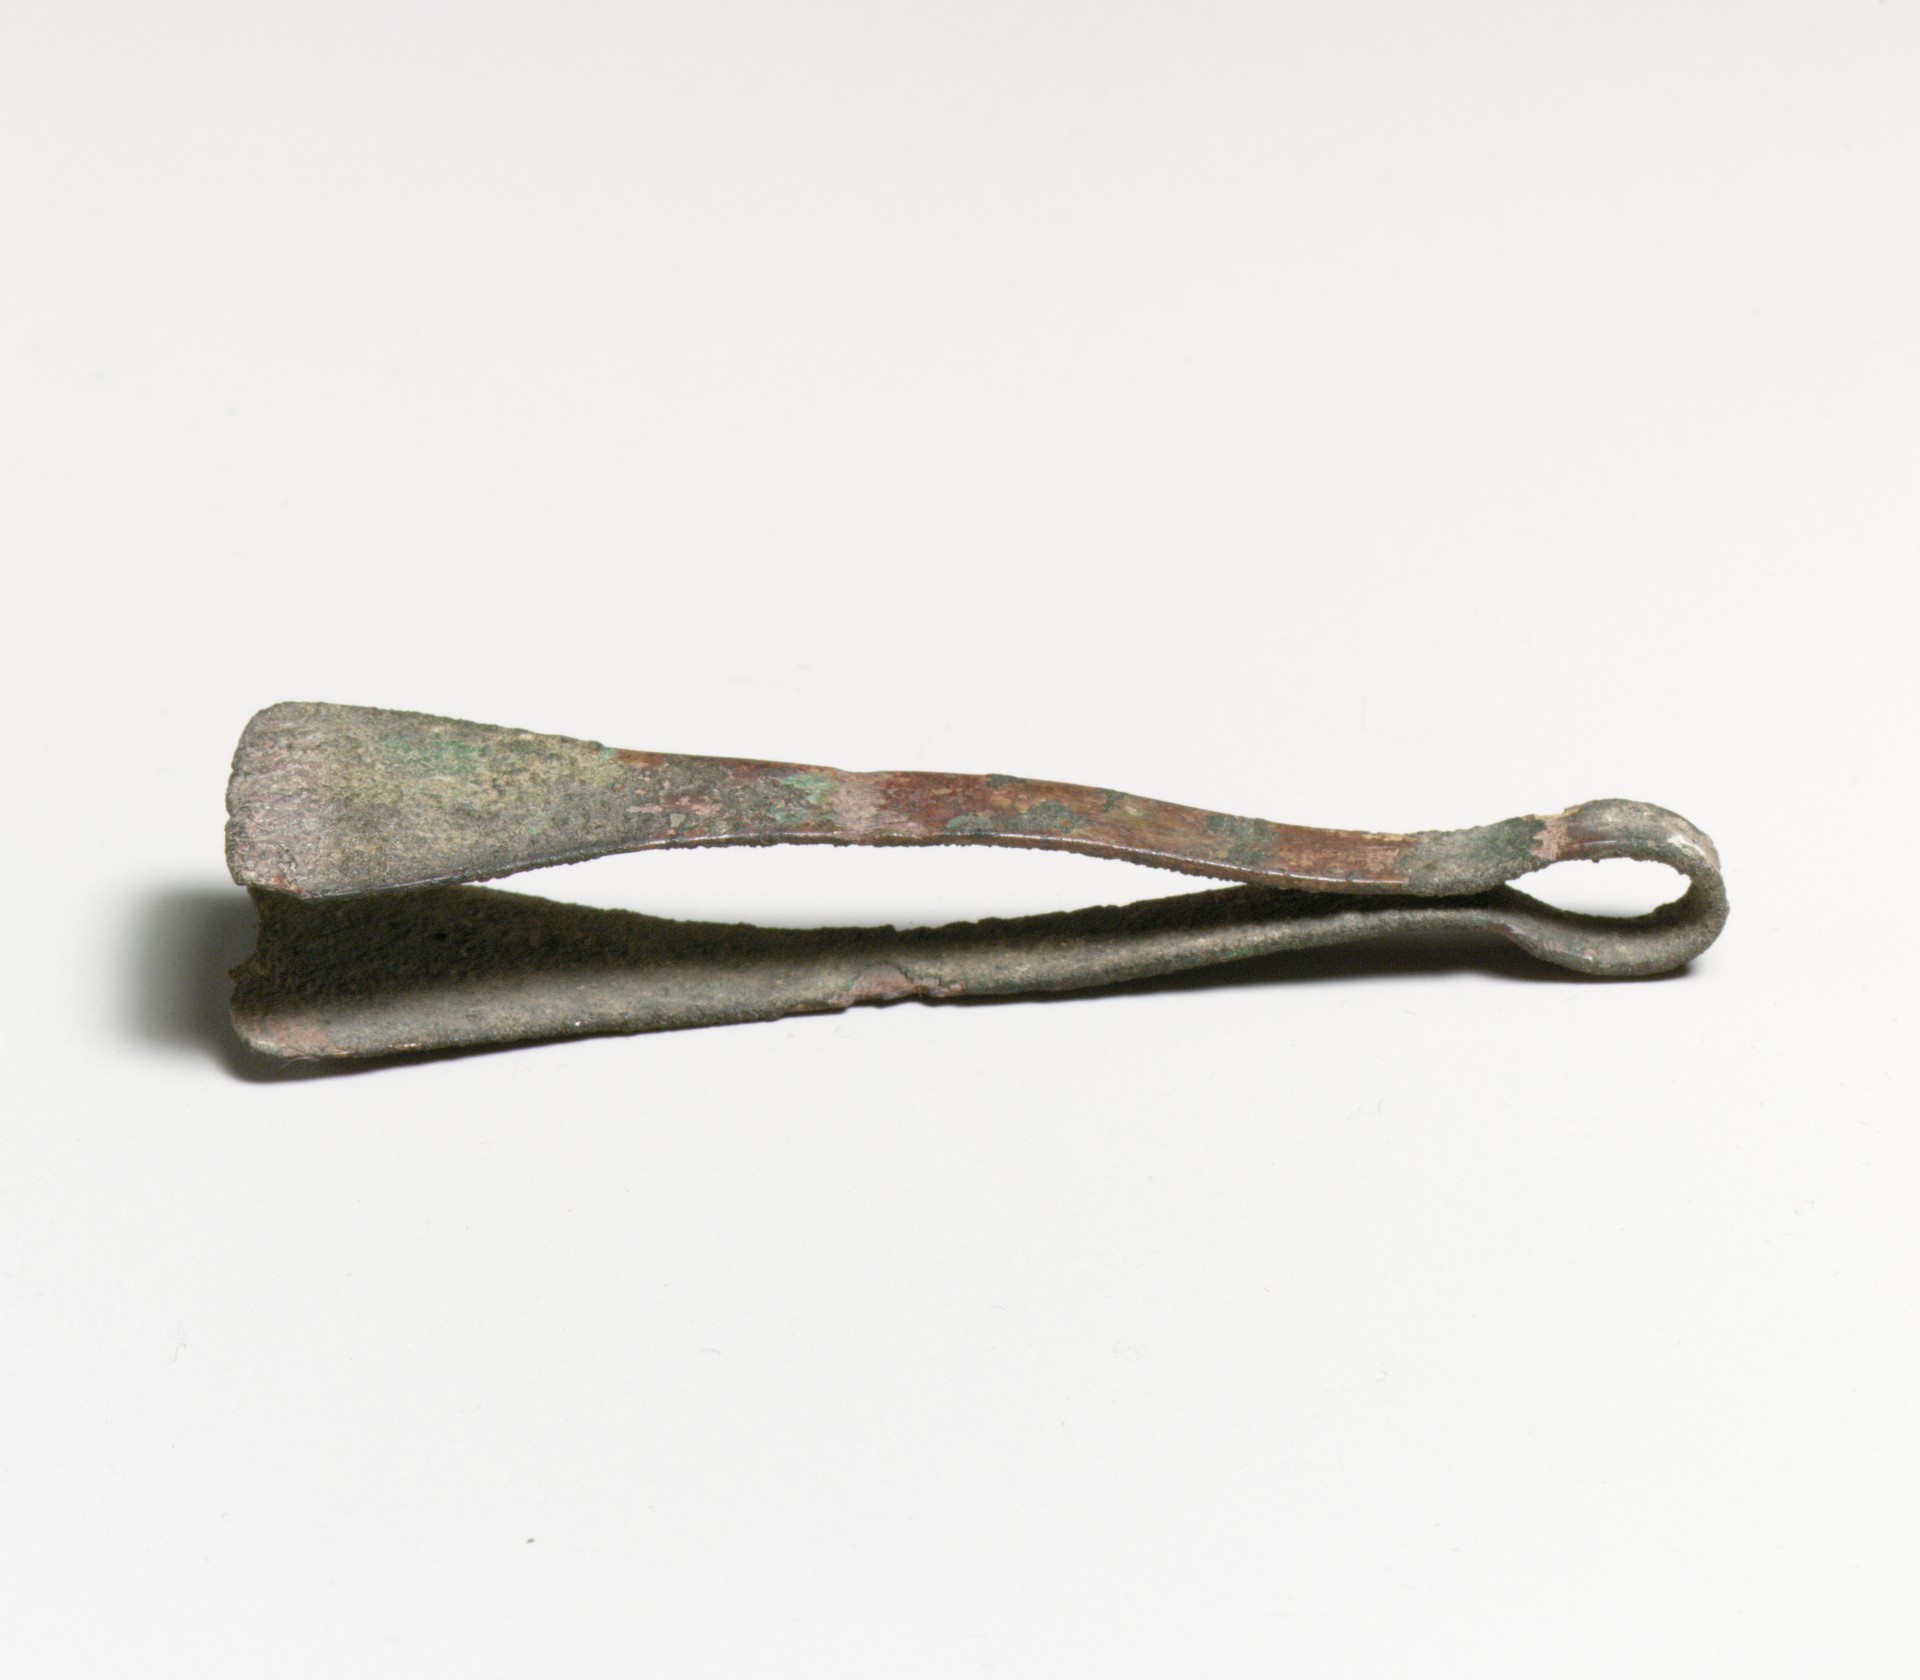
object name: tweezer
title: Tweezers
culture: cypriot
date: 3200-2000 BCE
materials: bronze